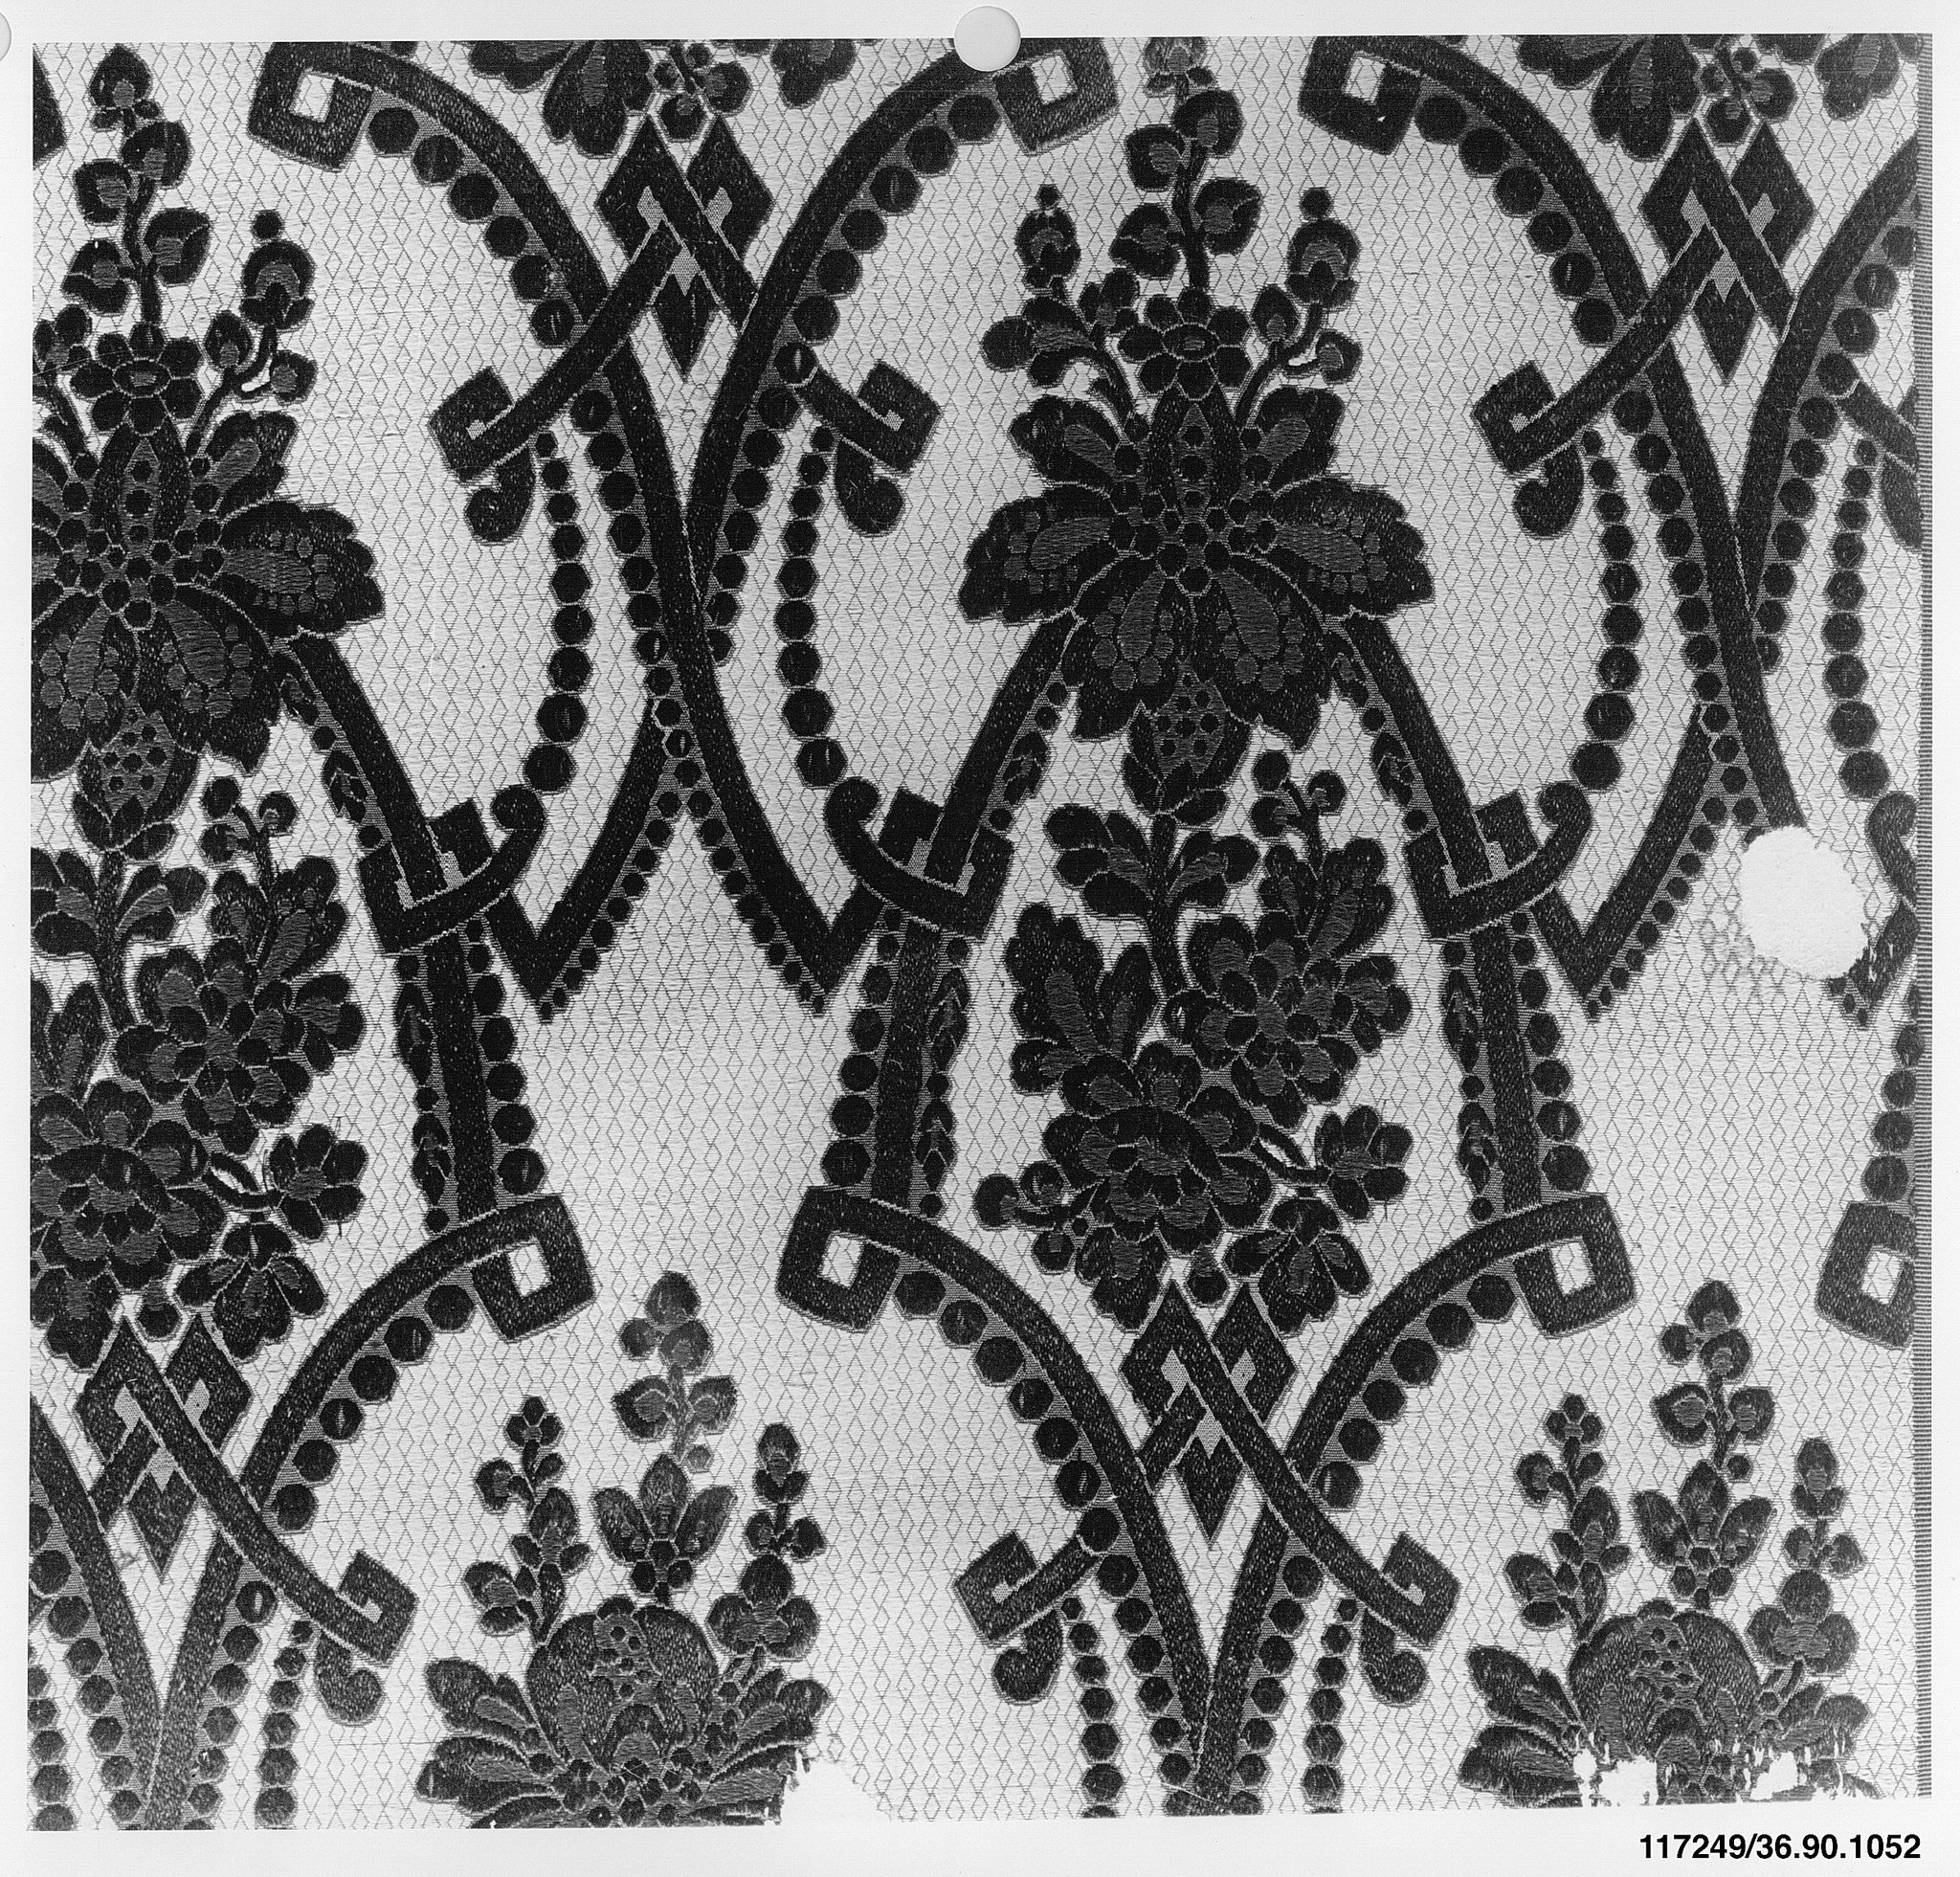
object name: piece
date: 1801-1900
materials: silk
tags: flowers,leaves